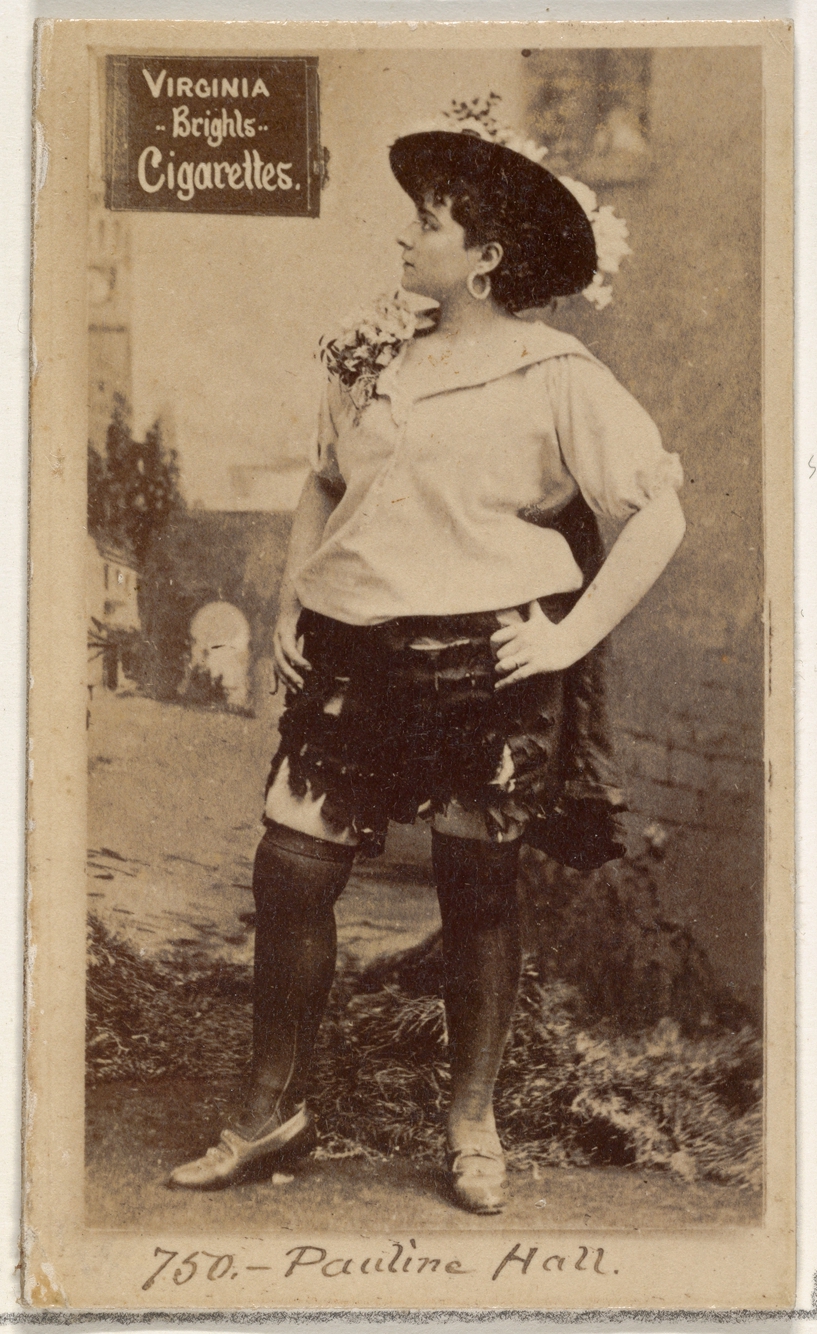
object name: photograph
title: Card 750, Pauline Hall, from the Actors and Actresses series (N45, Type 2) for Virginia Brights Cigarettes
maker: allen & ginter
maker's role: publisher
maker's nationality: american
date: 1888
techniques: albumen silver print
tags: profiles,women,actresses